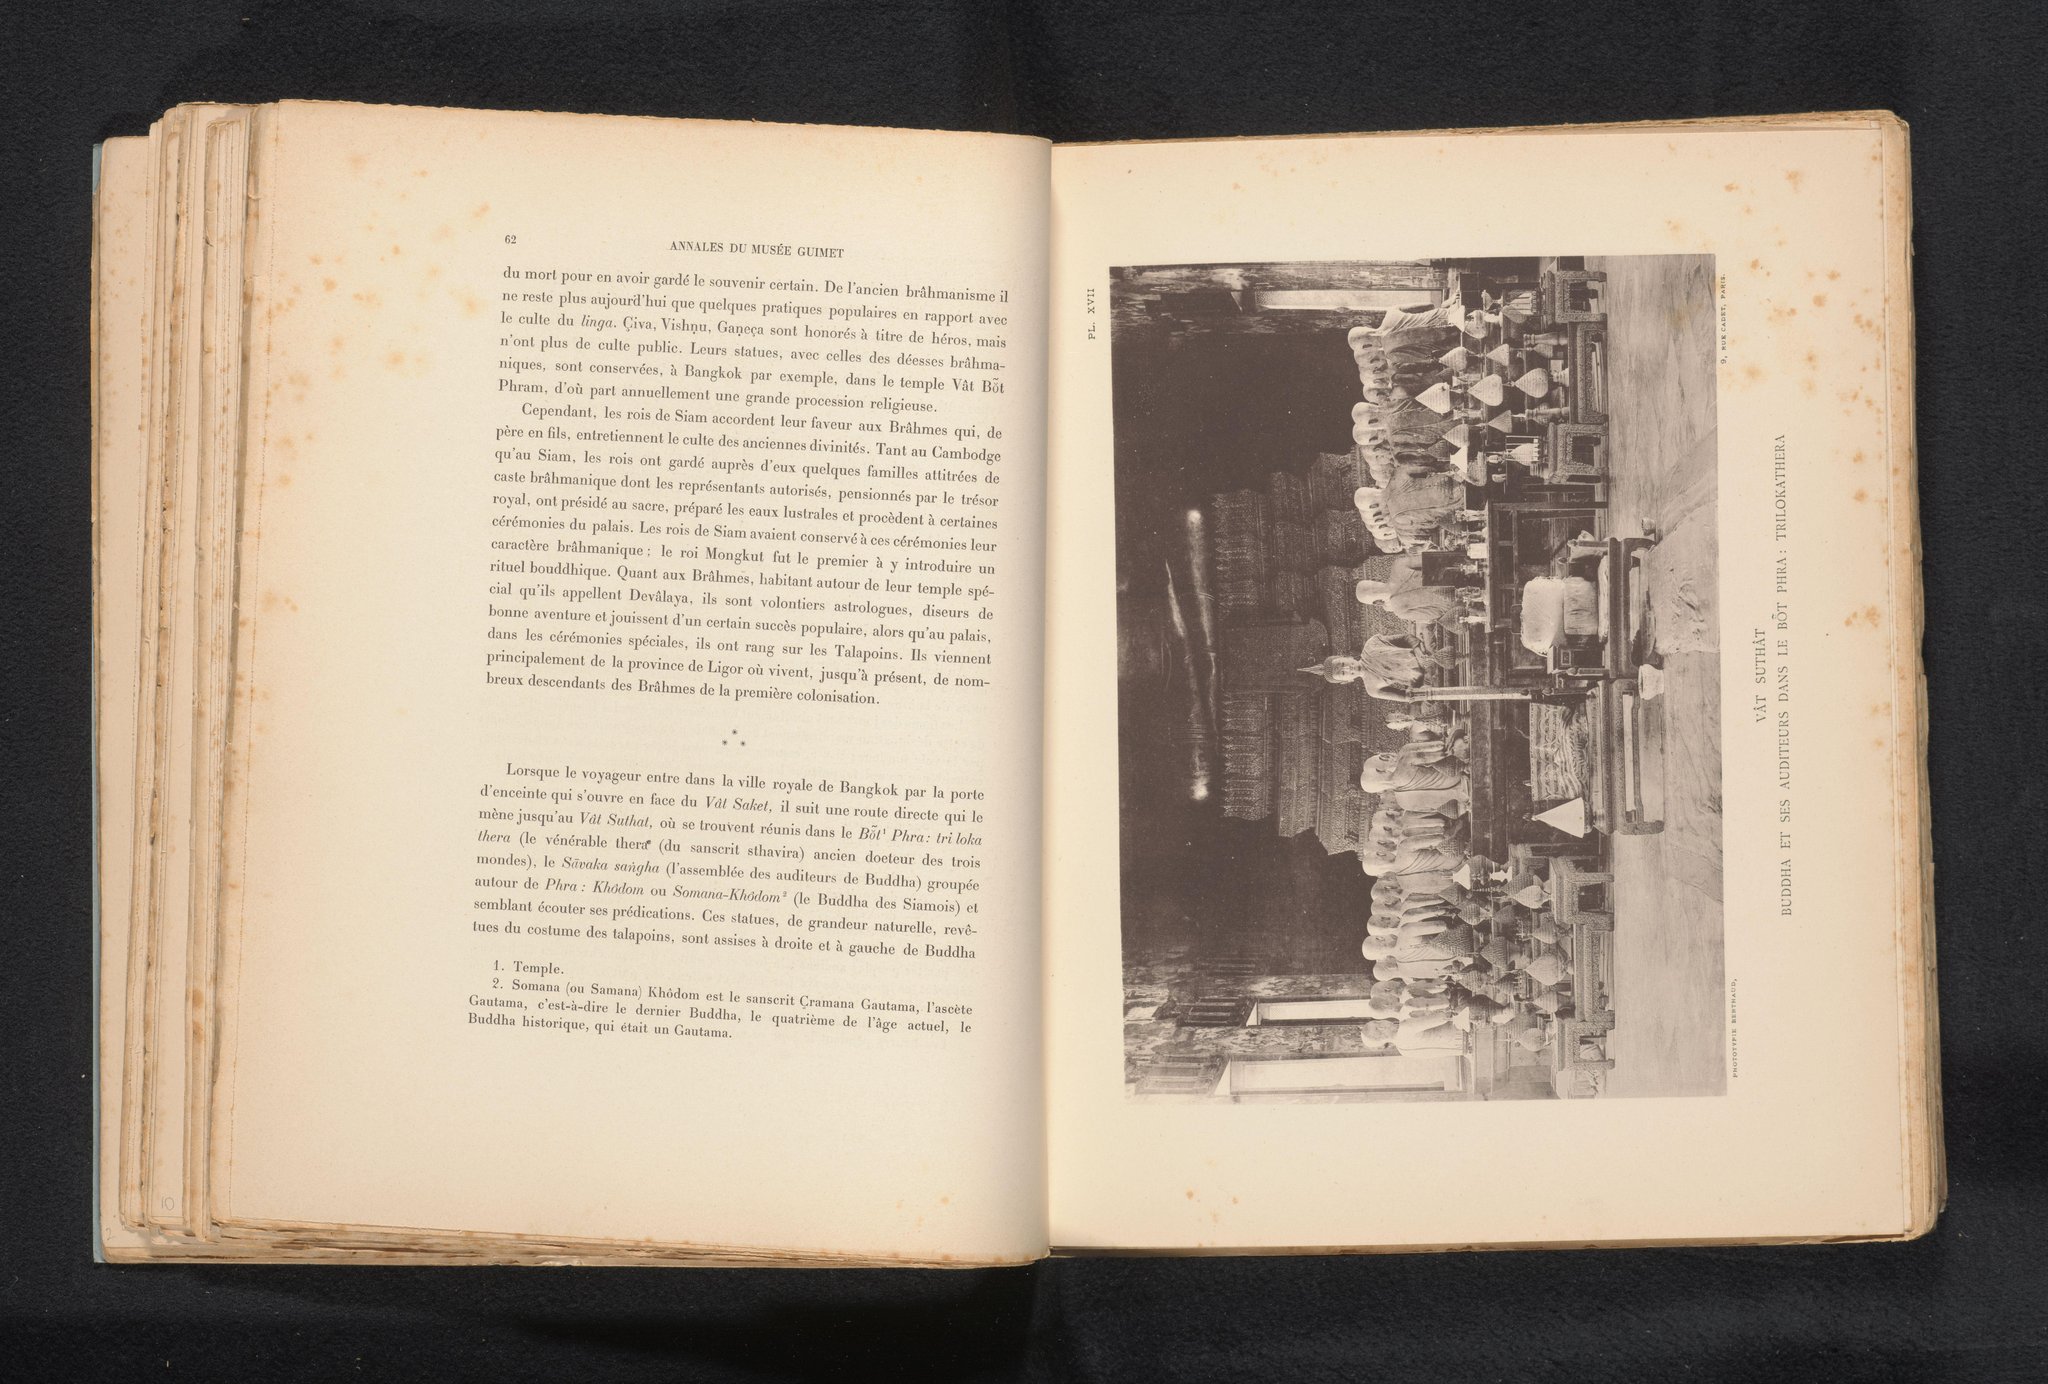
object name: photomechanical print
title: Vât Suthât - Buddha et ses auditeurs dans le Bõt Phra: Trilokathera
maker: michel berthaud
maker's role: publisher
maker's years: 1845-1912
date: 1890-1895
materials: paper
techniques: photograph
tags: temple, shrine ~ hinduism, buddhism, jainism, worship and devotion (in general) ~ hinduism, buddhism, jainism, religious functionaries ~ hinduism, buddhism, jainism, thailand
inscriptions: collector's mark: ‘Société d'Emulation de l'Ain/ Bourg/ Bibliothèque’, inscription: ‘Pl. XVII’